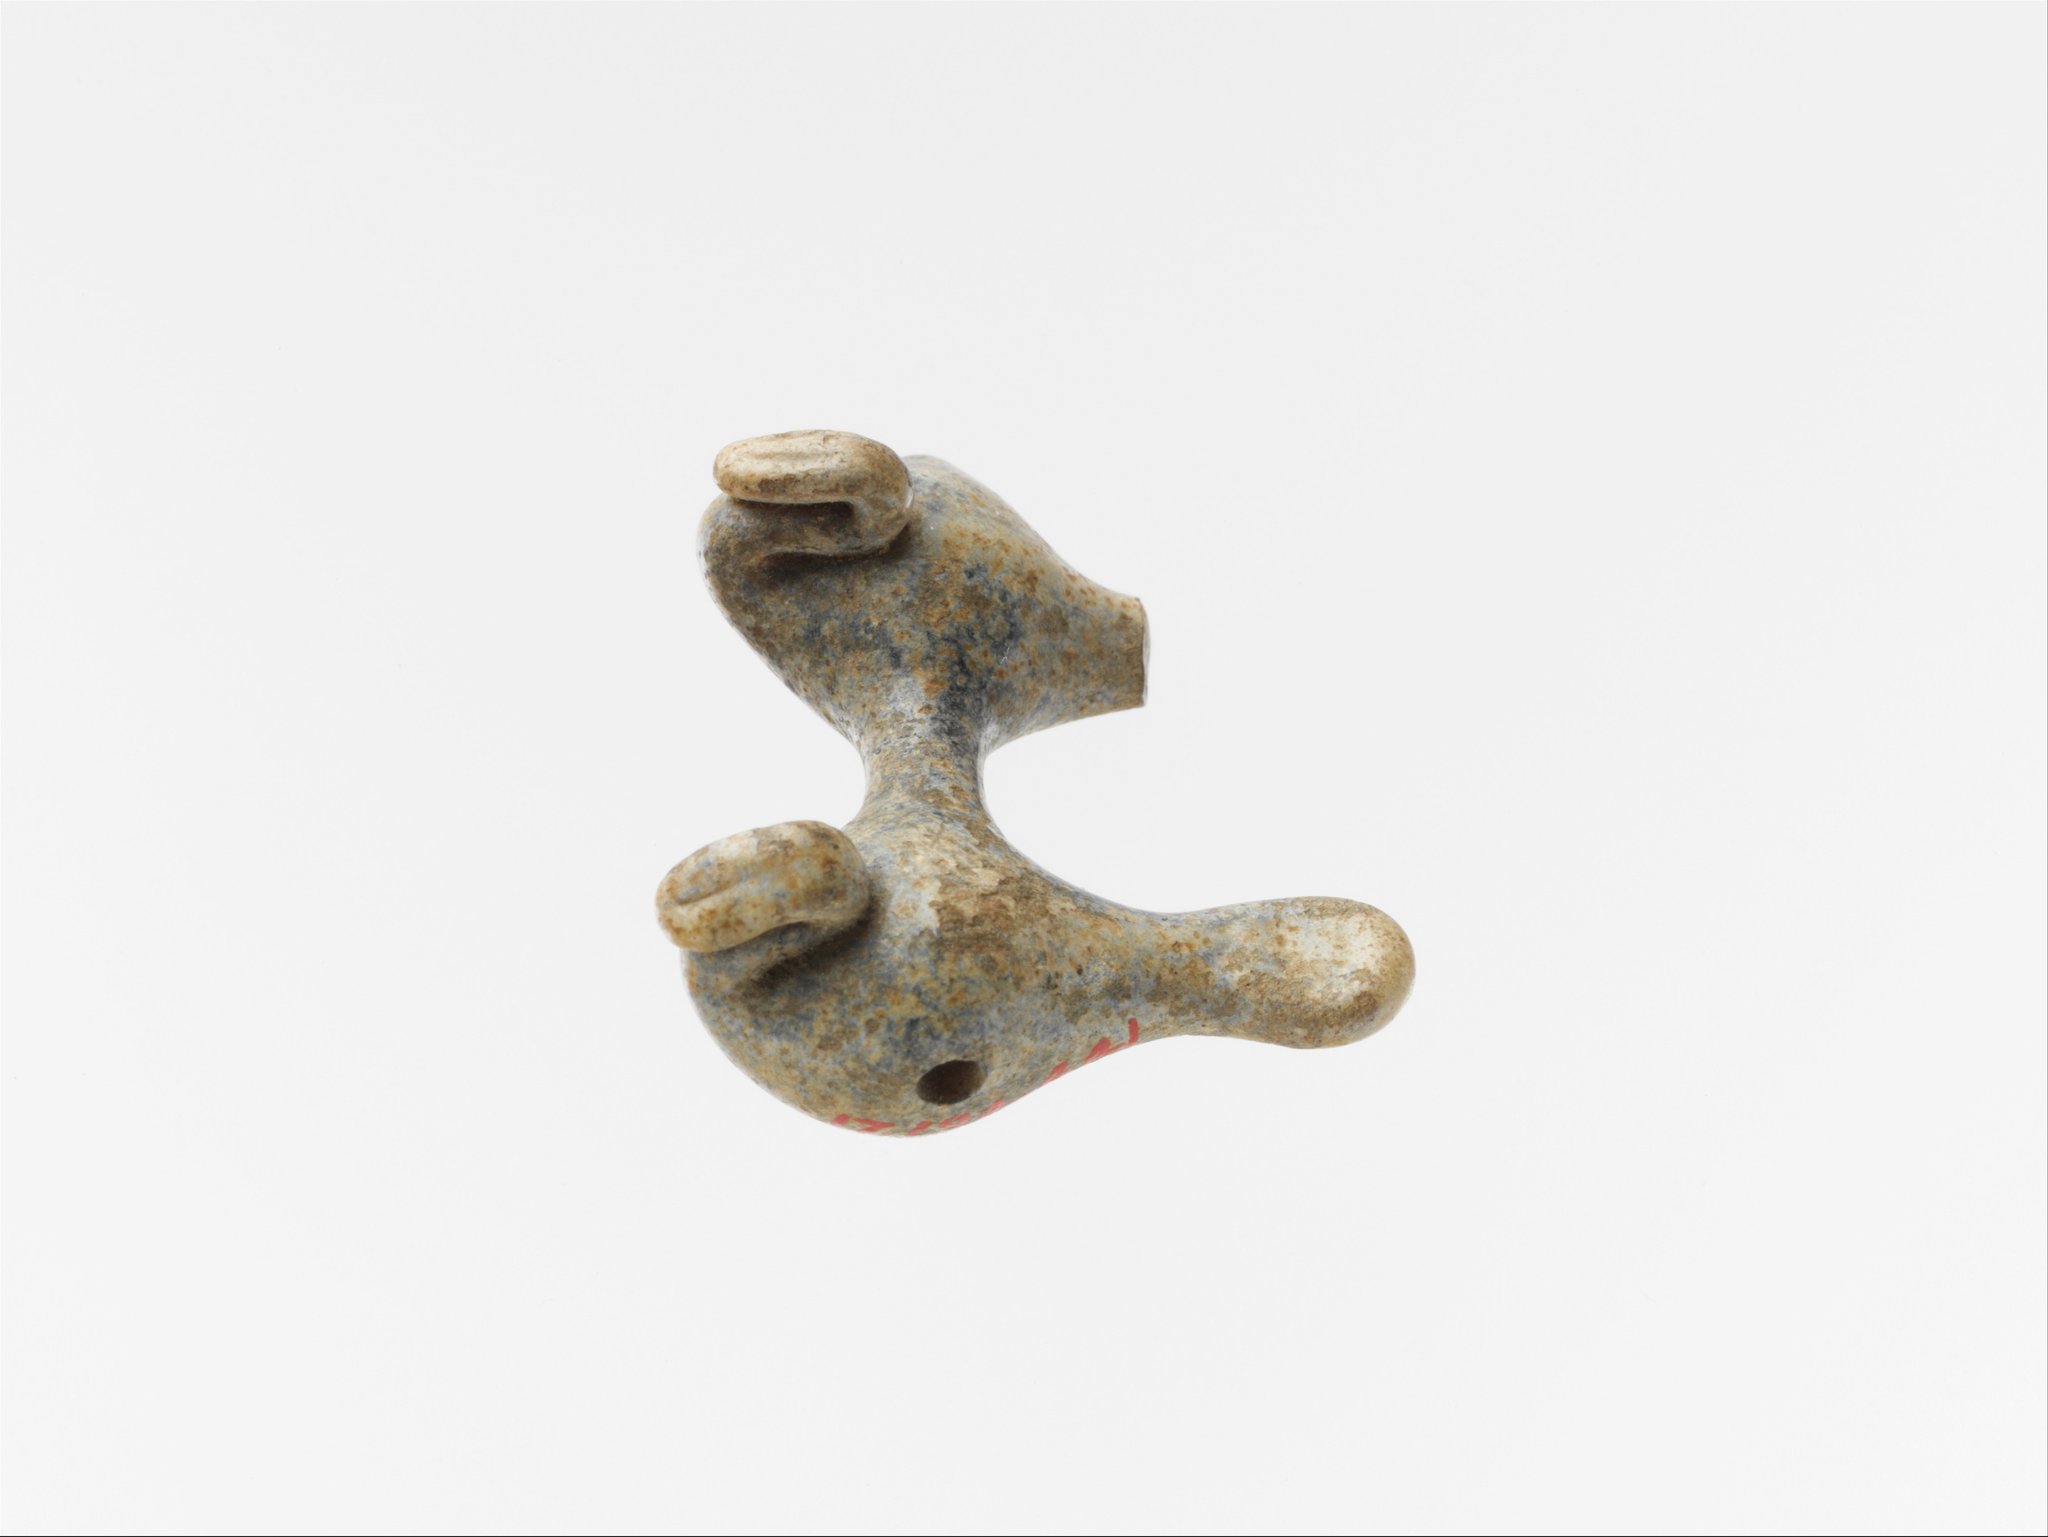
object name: ornament in the form of a duck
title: Glass pendant ornament in the form of a pair of birds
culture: egyptian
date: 1400-1101 BCE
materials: glass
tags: birds